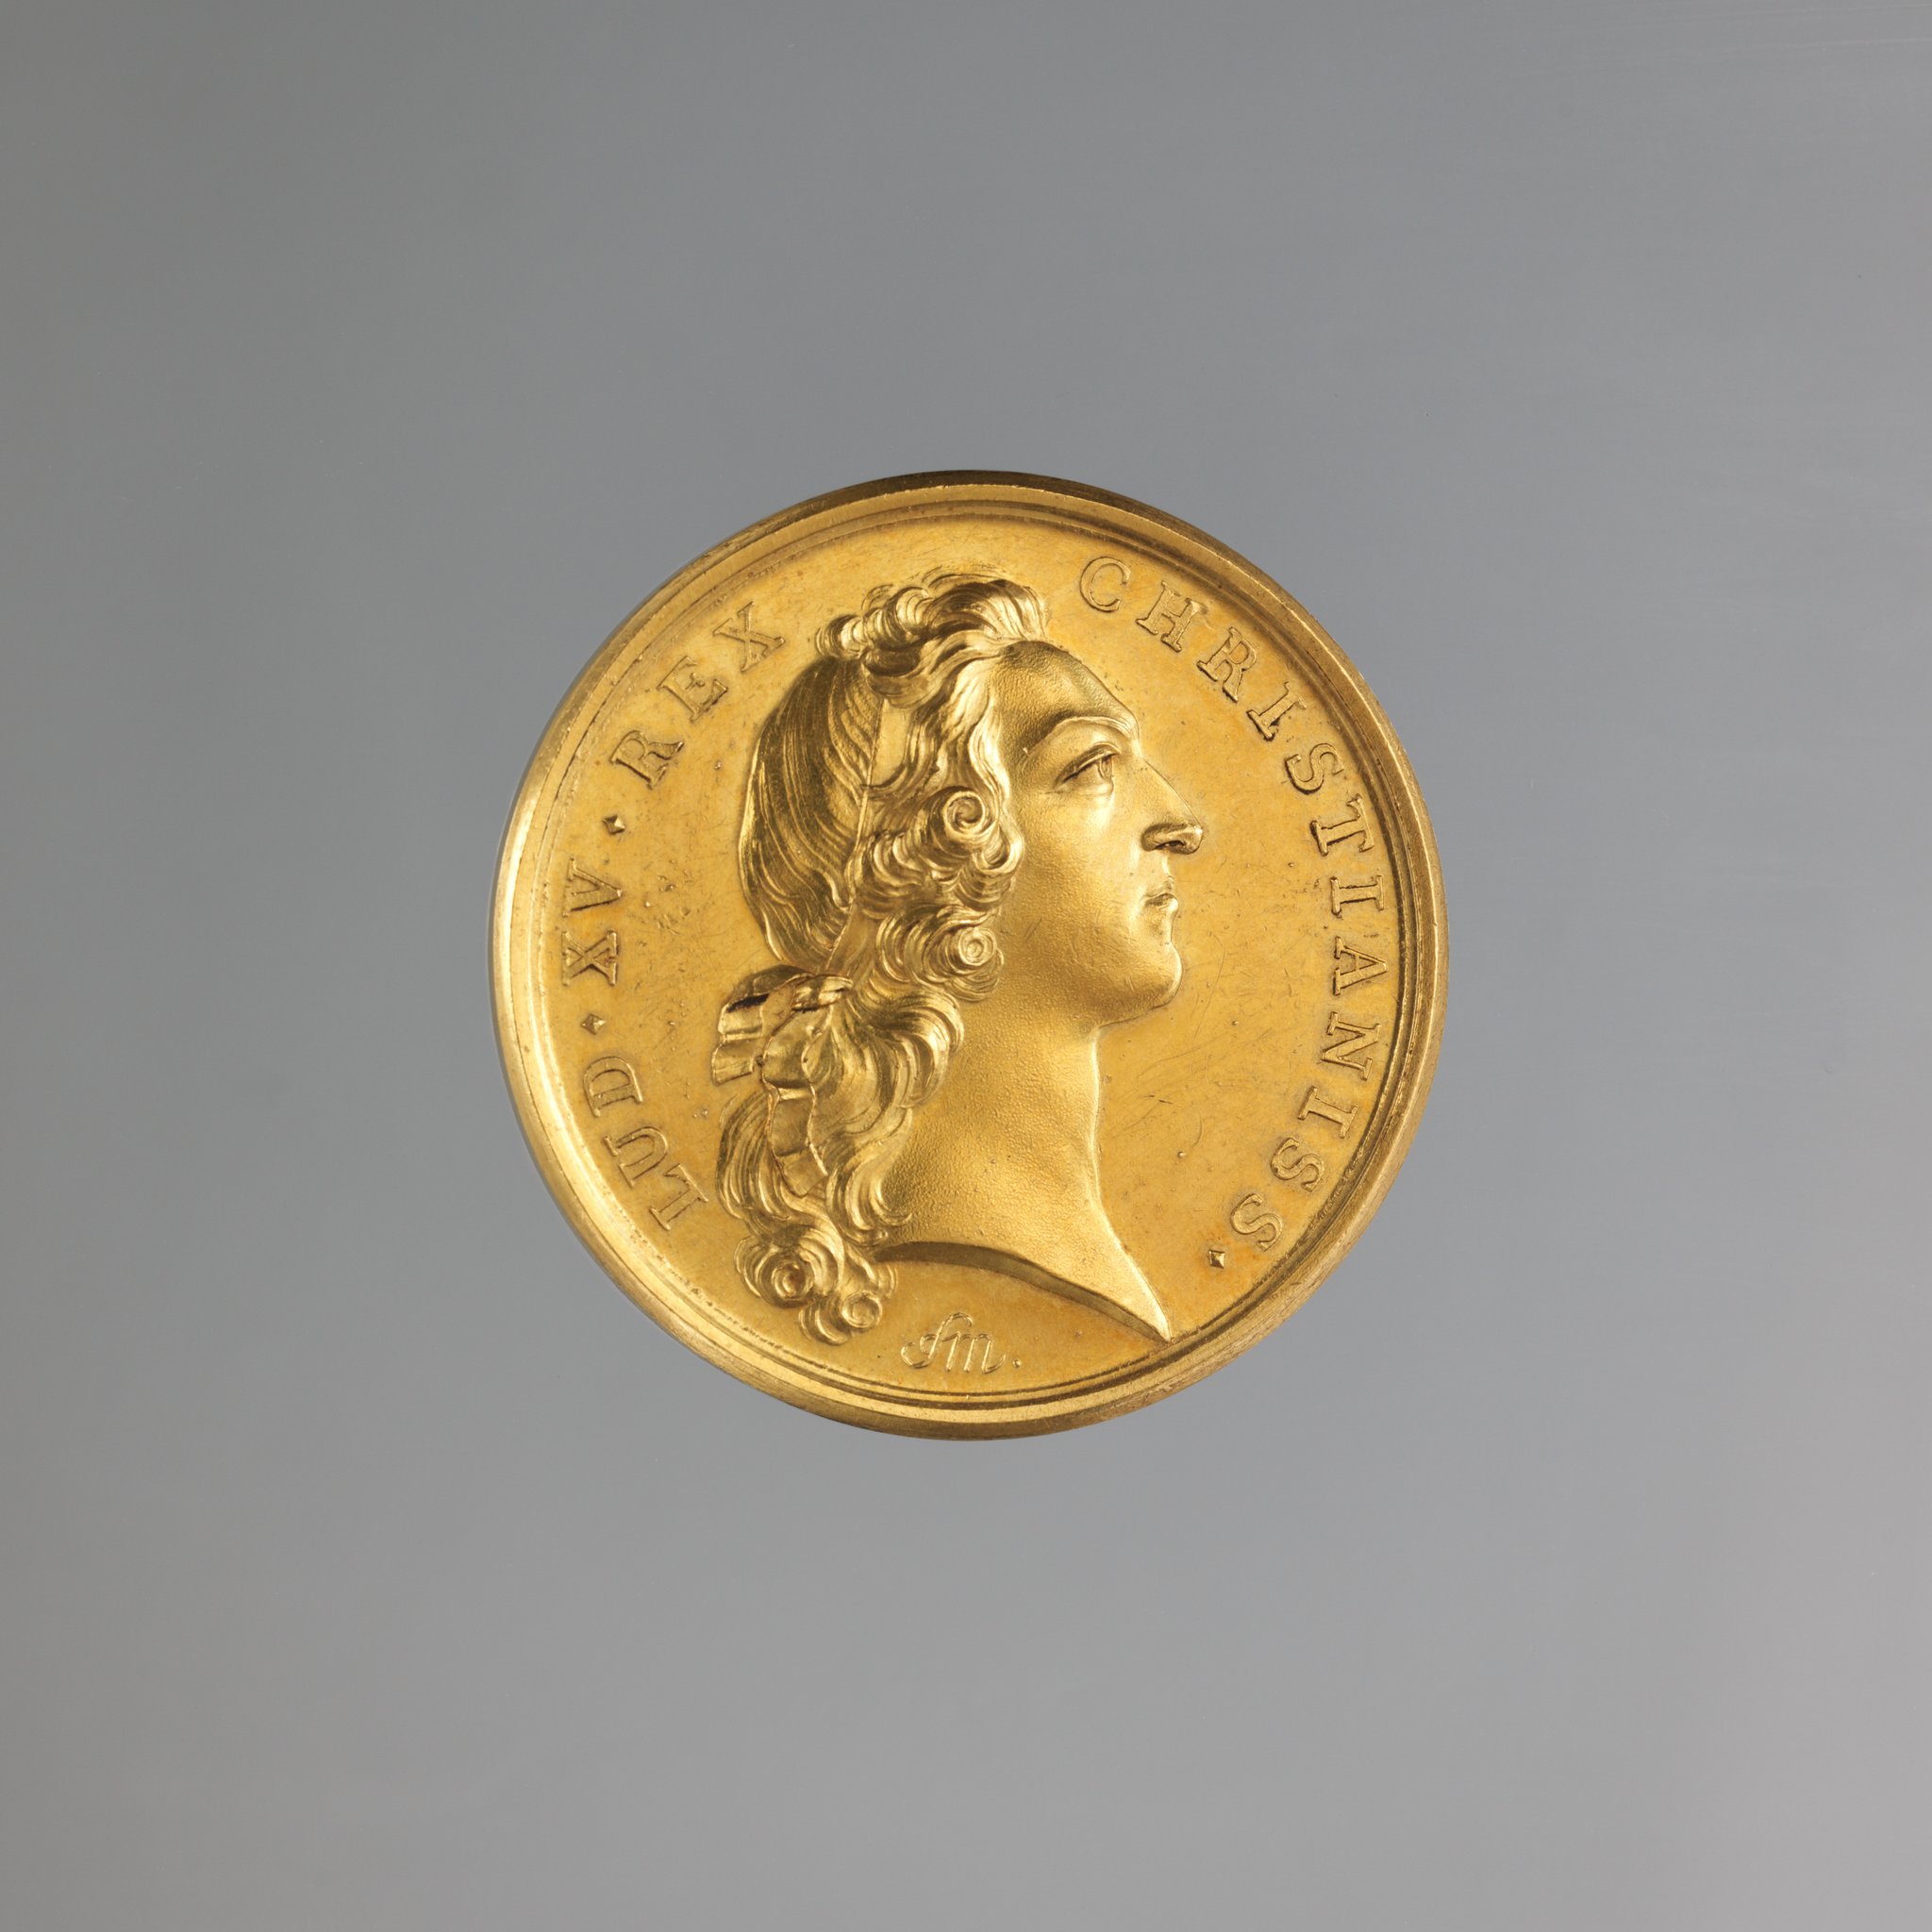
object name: medal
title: Louis XV: Peace Concluded at Aix-la-Chapelle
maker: françois joseph marteau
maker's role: maker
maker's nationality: french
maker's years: 1720-1759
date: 1748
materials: gold